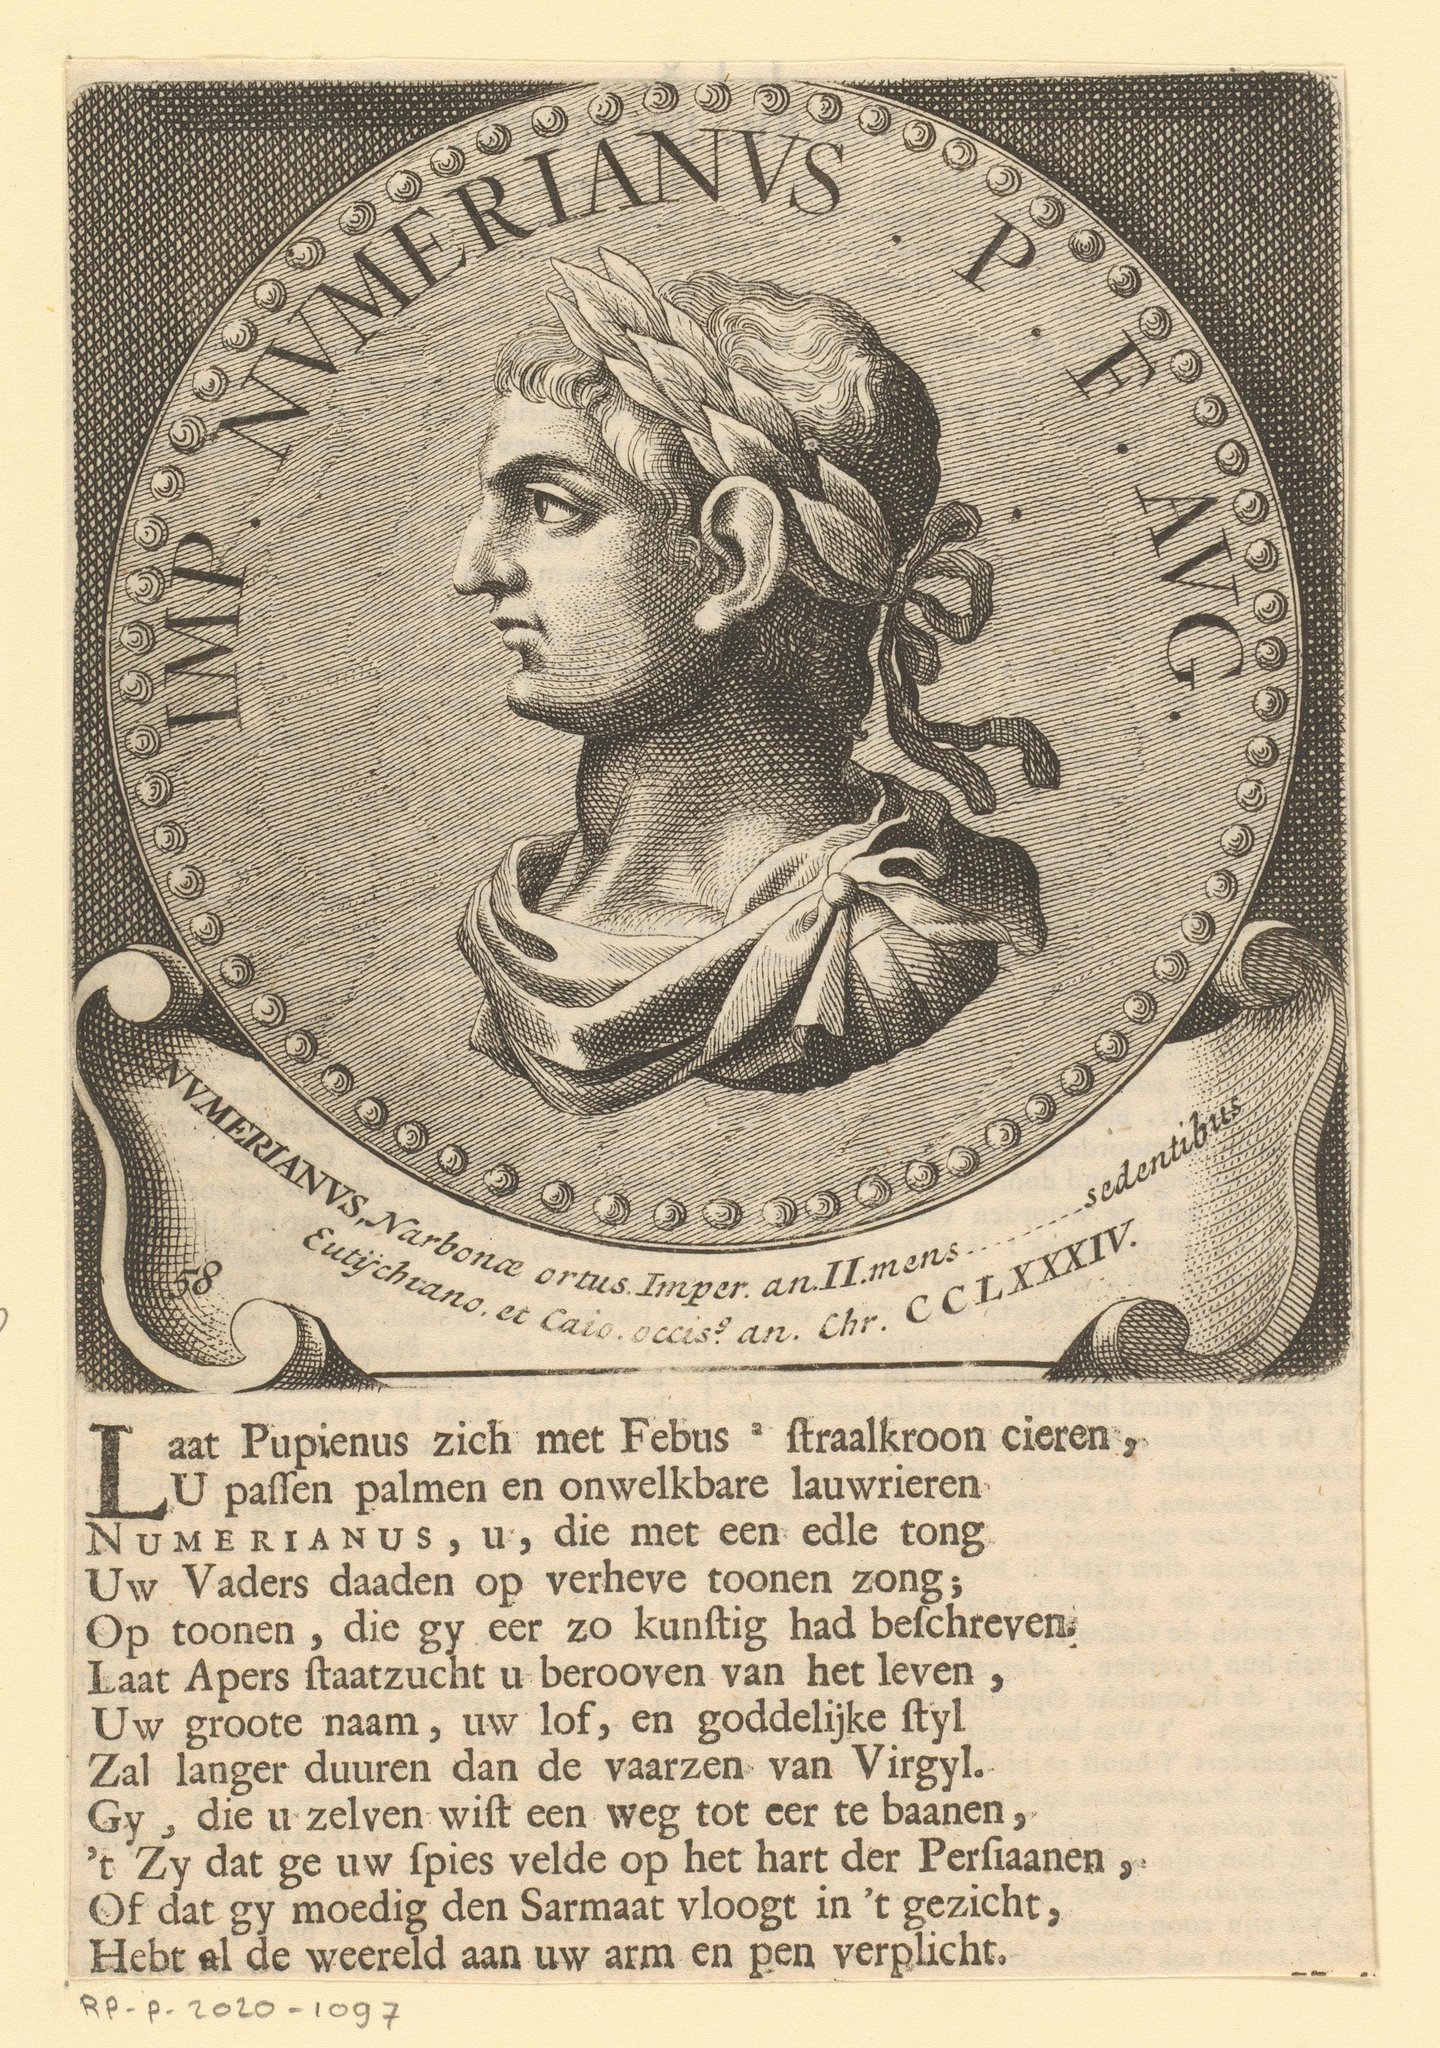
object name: print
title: Portret van keizer Numerianus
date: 1697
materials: paper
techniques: engraving, etching, letterpress printing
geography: utrecht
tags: historical persons, emperor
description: Prent uit: Bogaert, Abraham. De Roomsche monarchy, vertoont in de muntbeelden der westersche en oostersche keizeren (...). Utrecht: François Halma en Willem van de Water, 1697, p. 223. Eerste staat verschenen in een grotere prent met twaalf portretten, gedateerd 1695.